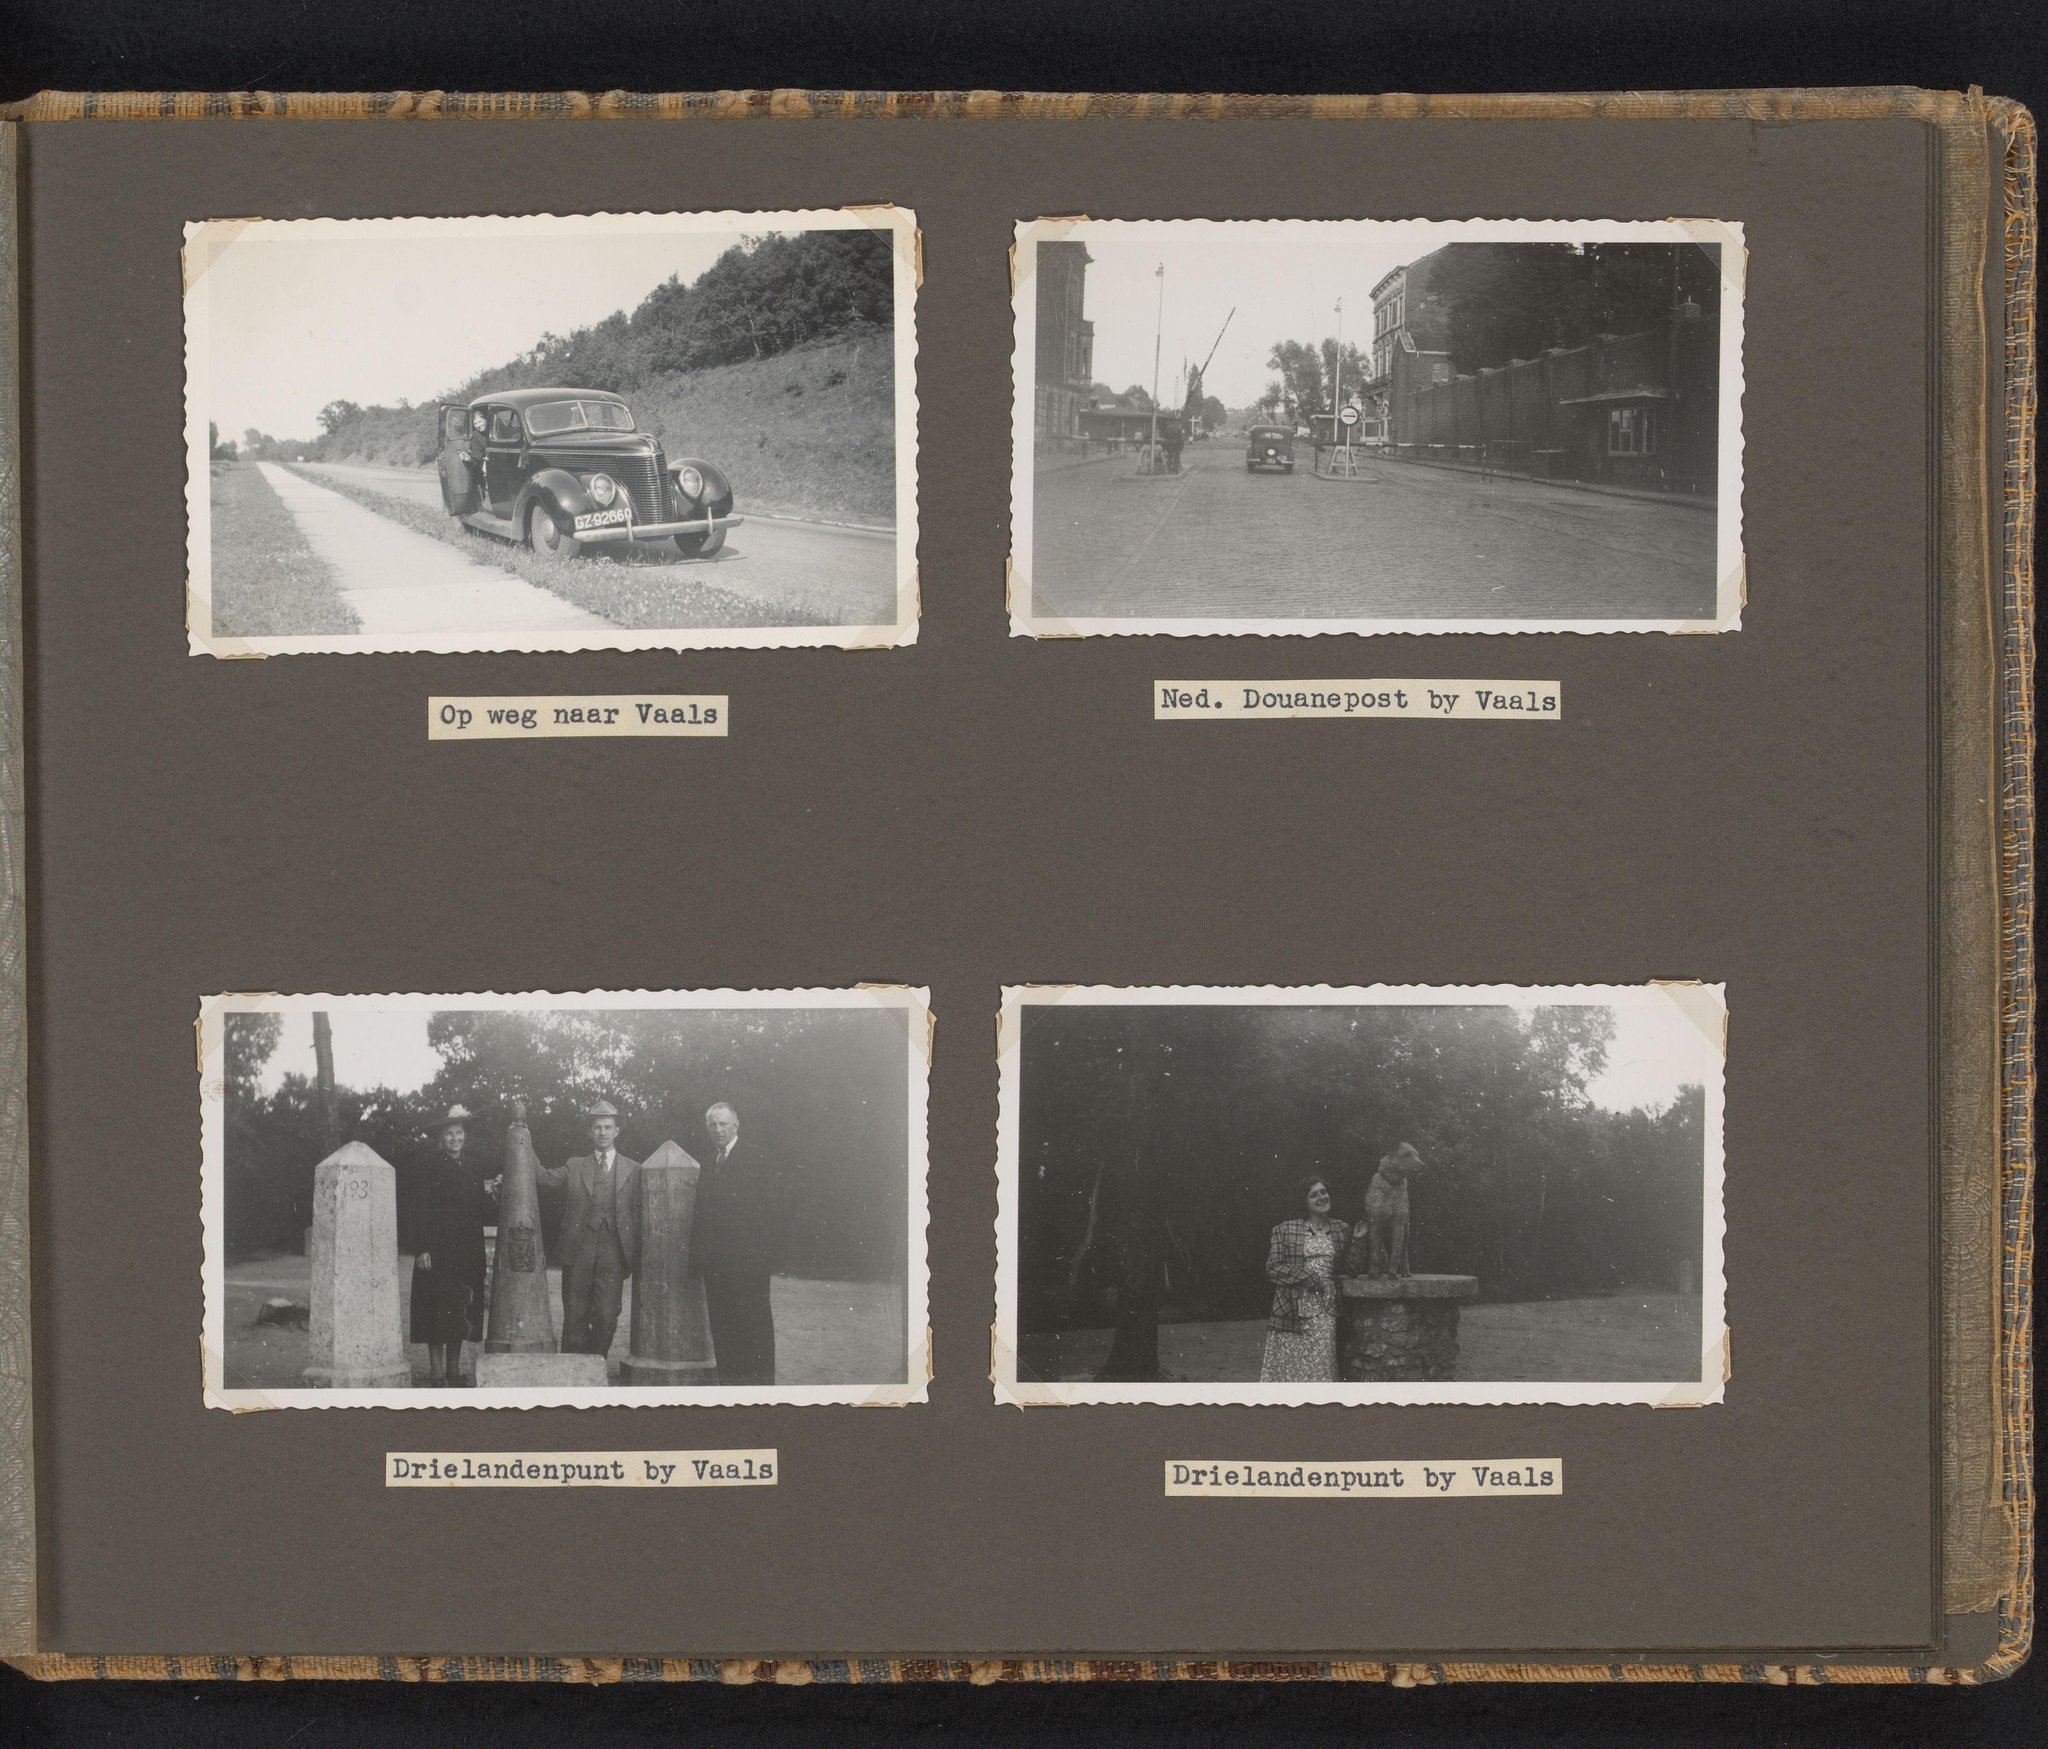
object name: photograph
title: Vaals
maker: Anonymous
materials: paper, photographic support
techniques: gelatin silver print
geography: vaals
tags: the family travelling, on holiday, outing, pleasure trip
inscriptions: inscription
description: Albumblad met vier foto's bij het Drielandenpunt bij Vaals. Onder de foto's uitgeknipte papiertjes met getypte opschriften. Onderdeel van het eerste fotoalbum met foto's van de twee fietstochten van vader en zoon door Nederland in september 1939 en juli 1940 en een autotrip met het gezin door Nederland, België en Luxemburg in juni 1949.